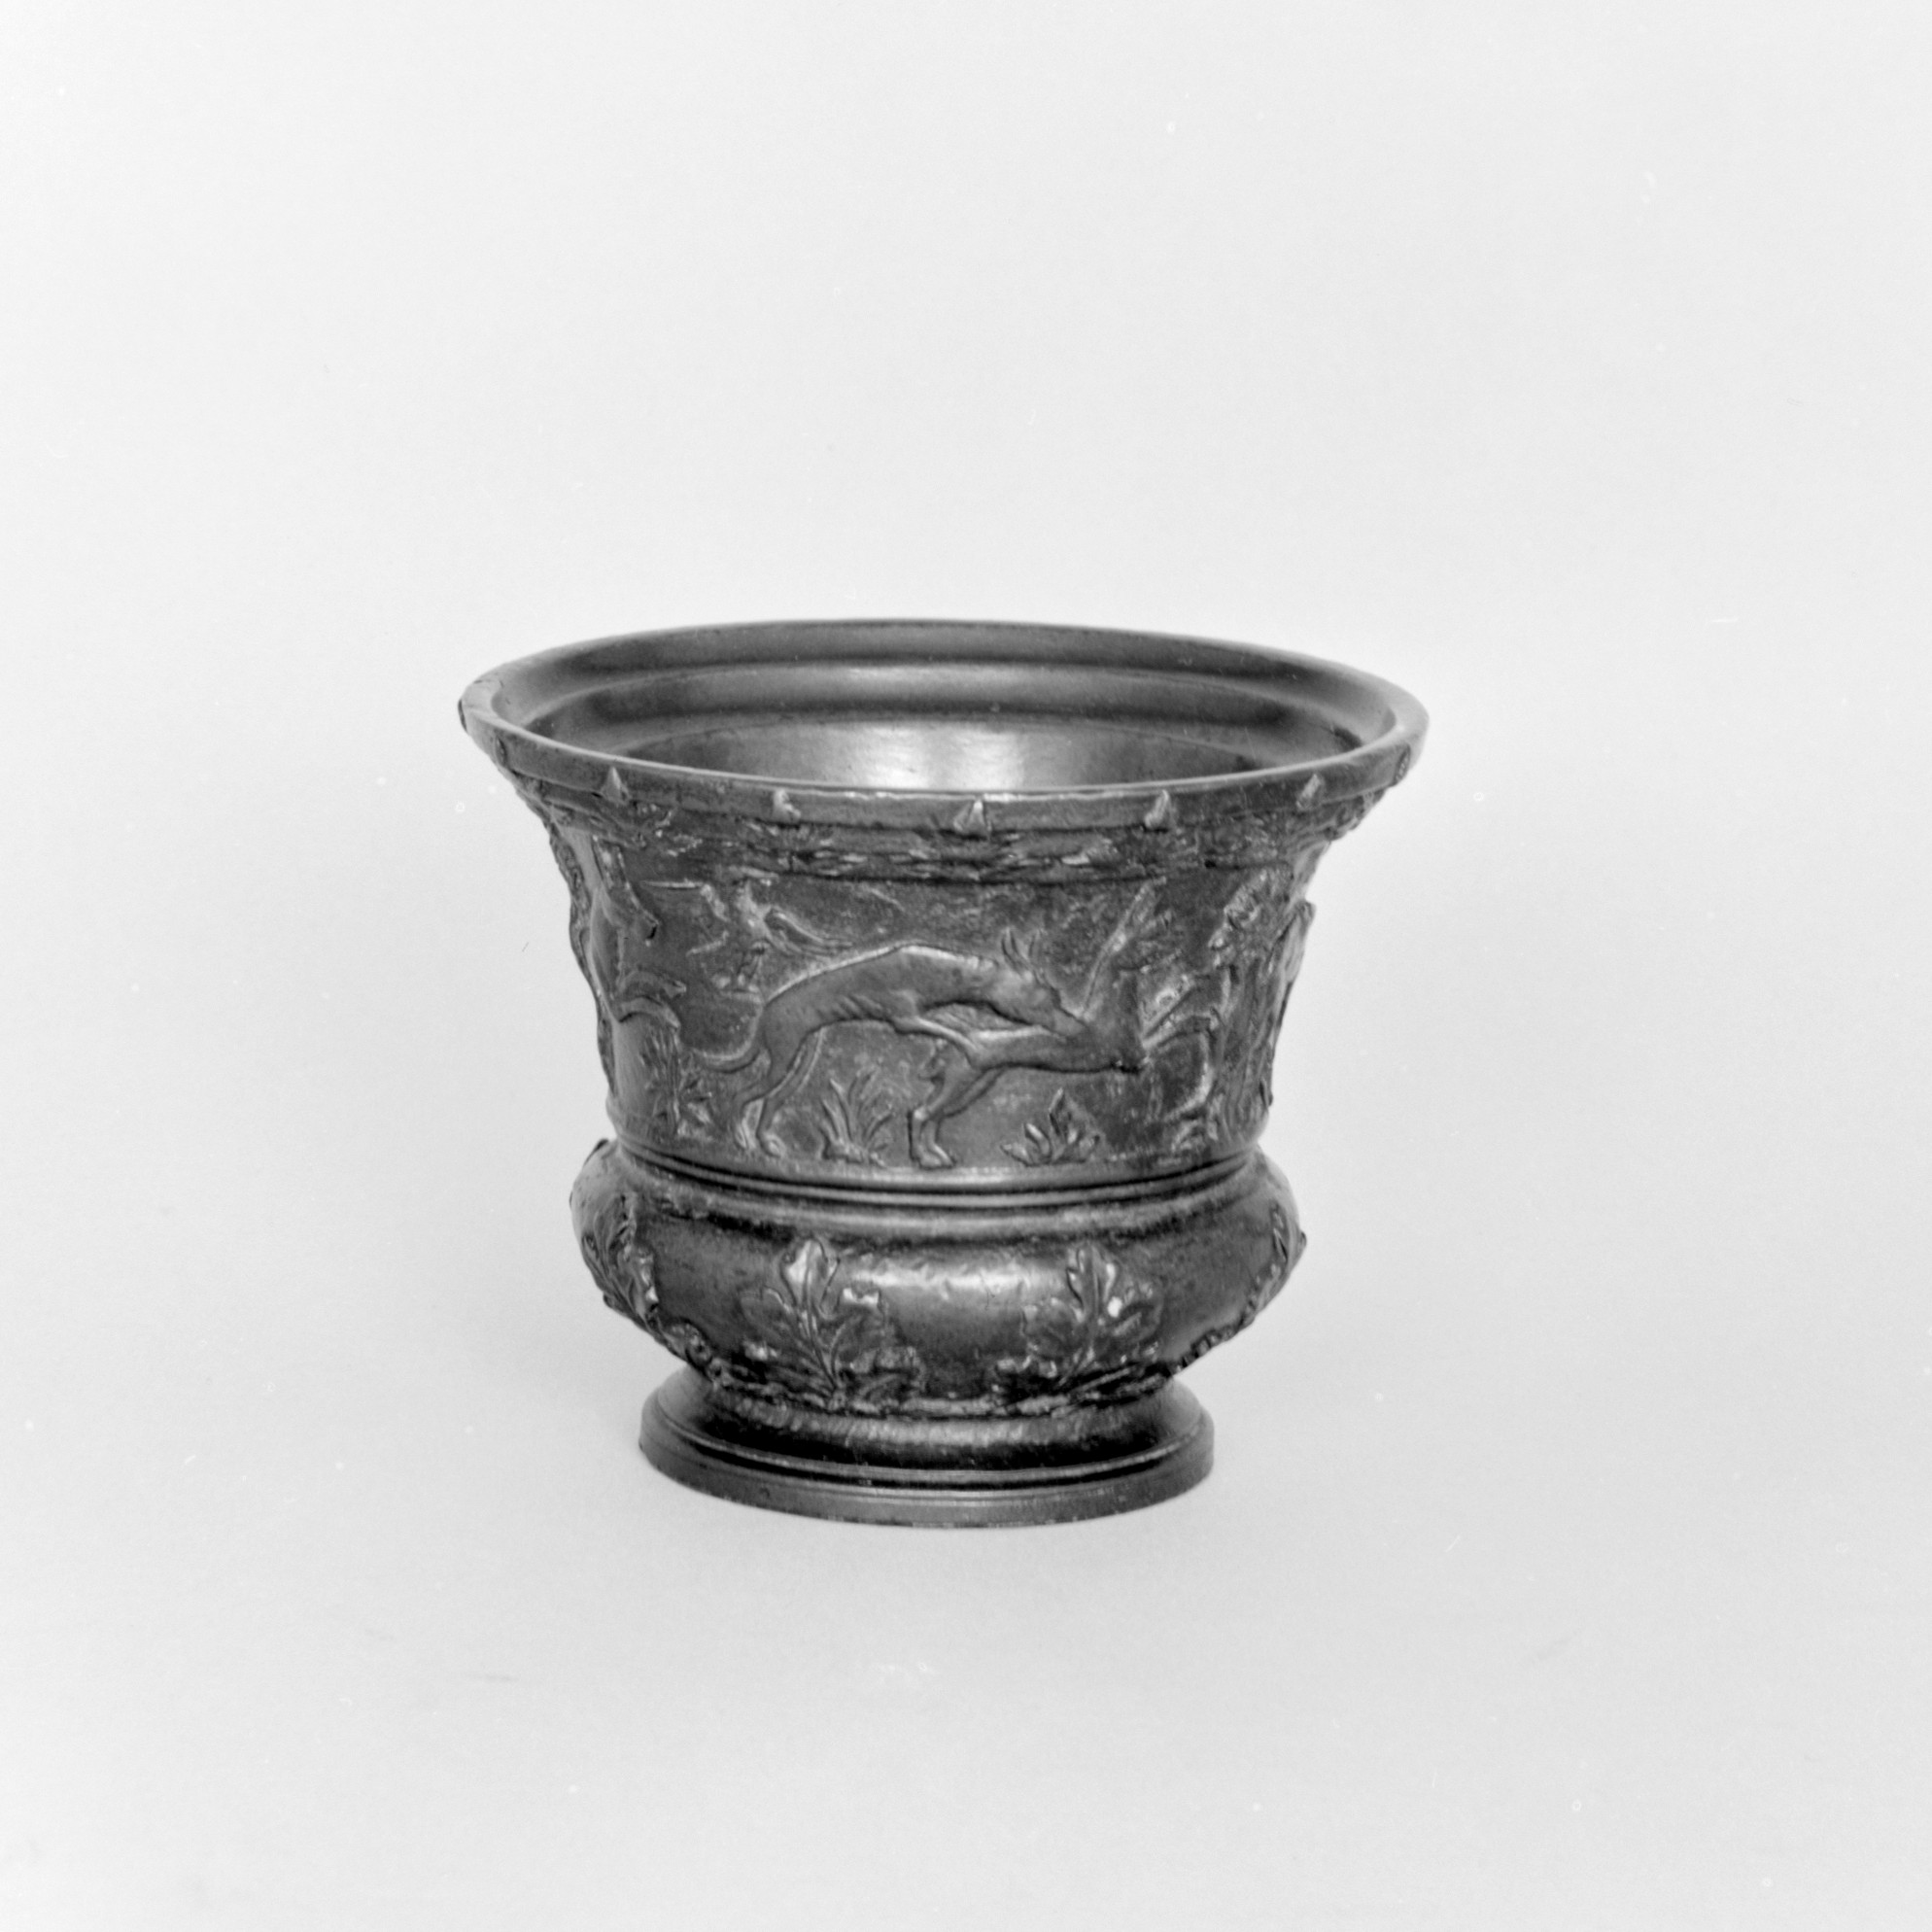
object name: mortar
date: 1501-1600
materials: bronze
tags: animals